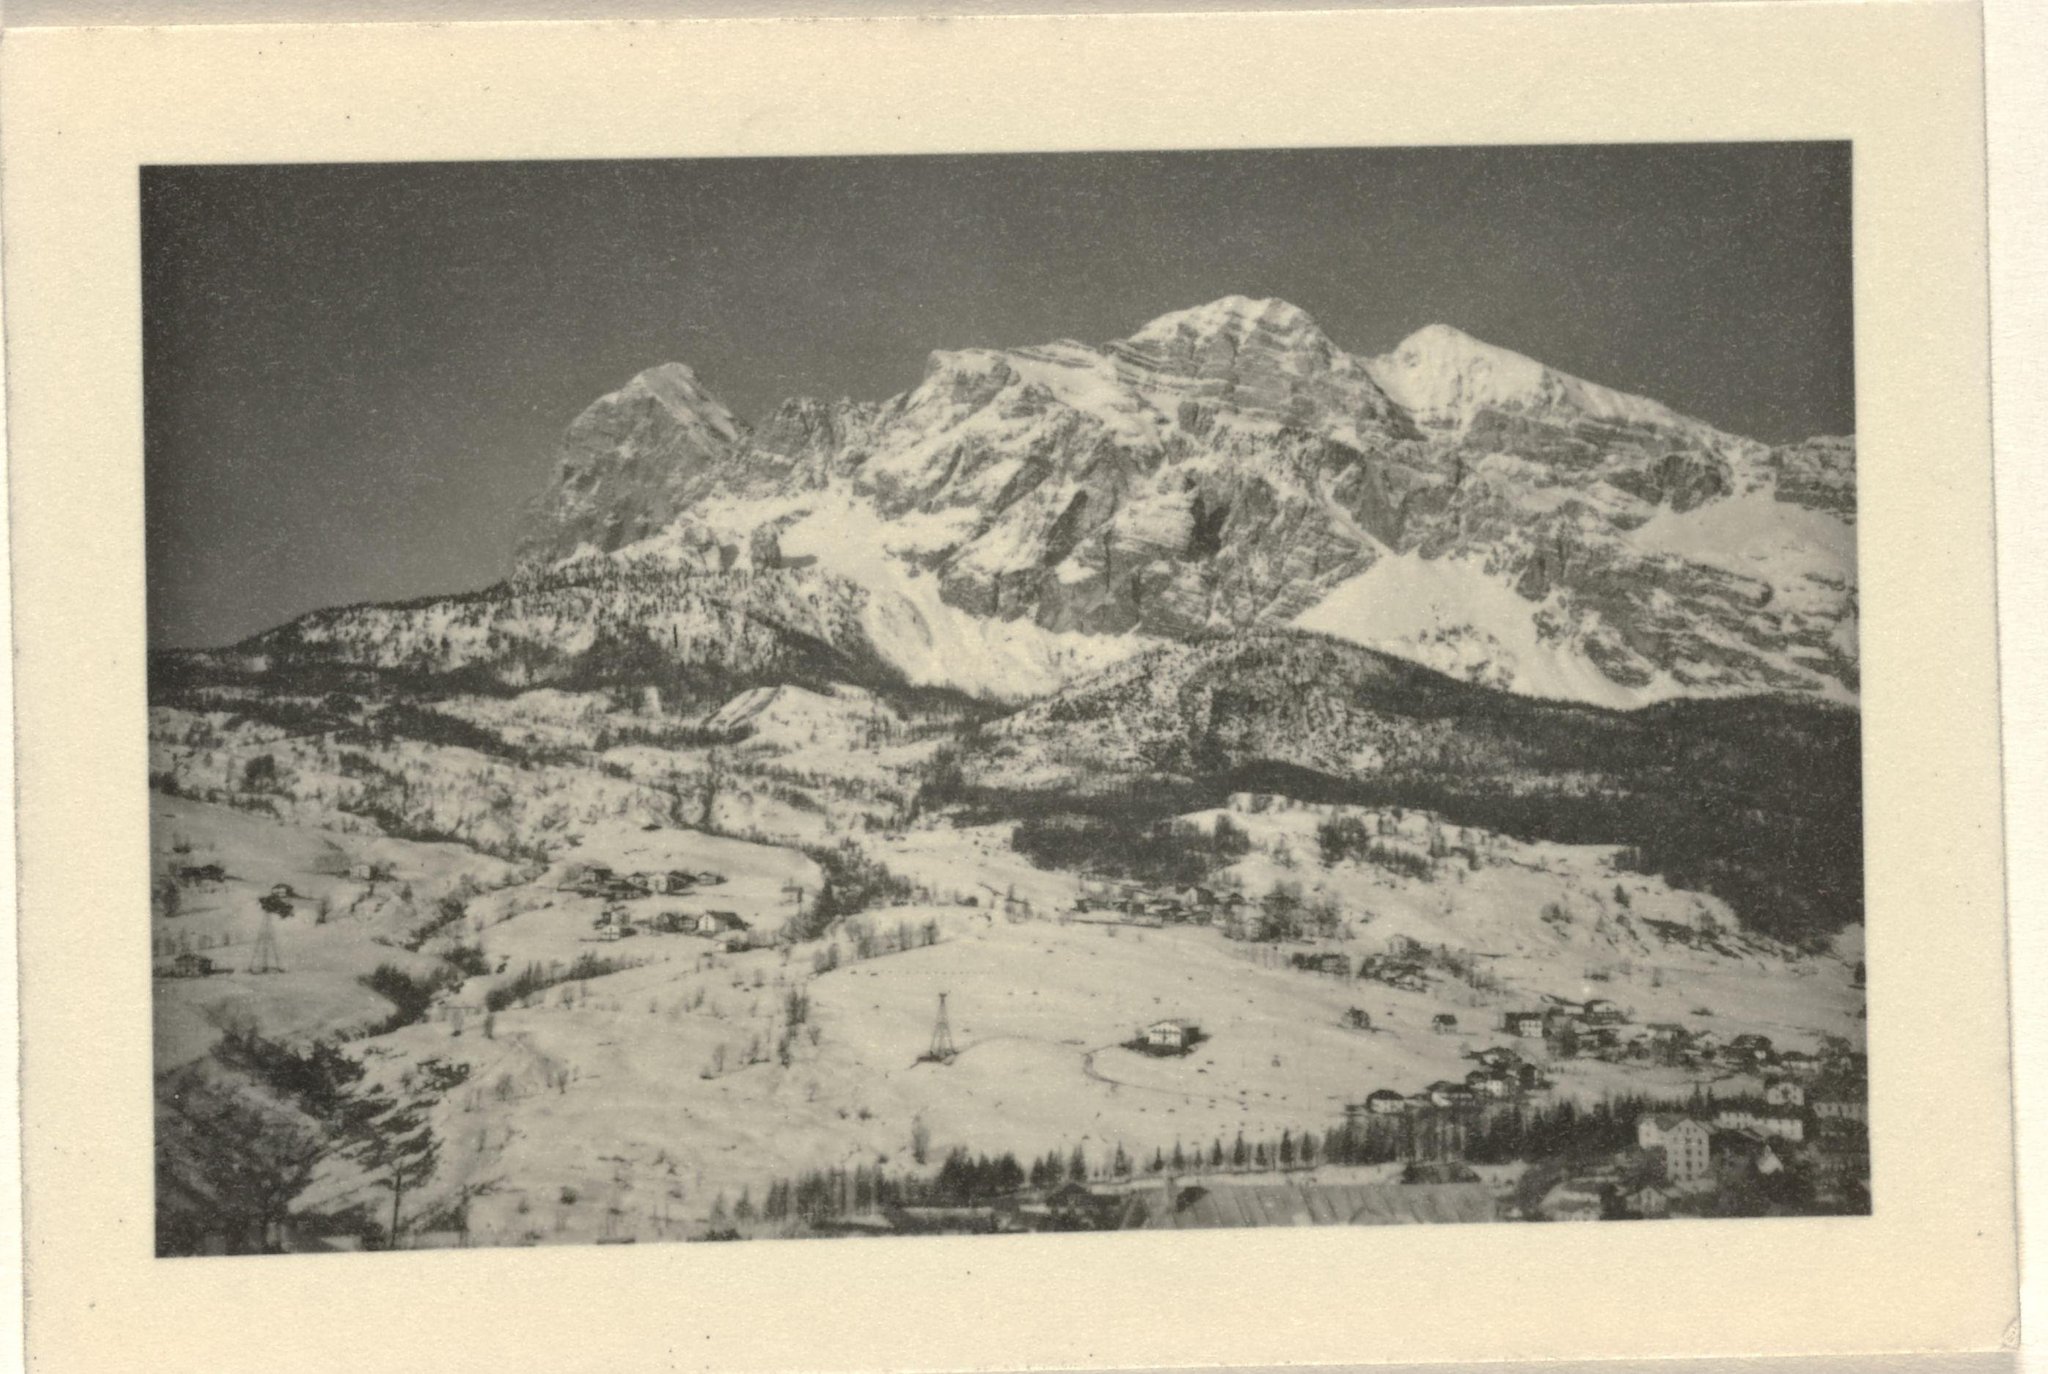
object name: photograph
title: Besneeuwd berglandschap, met bomen en gebouwen op de voorgrond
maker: Anonymous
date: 1930-1975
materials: photographic support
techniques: gelatin silver print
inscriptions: number: ‘Blick von Palner bristallo auf Tofund I.II.III.’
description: Besneeuwd berglandschap, met bomen en gebouwen op de voorgrond.